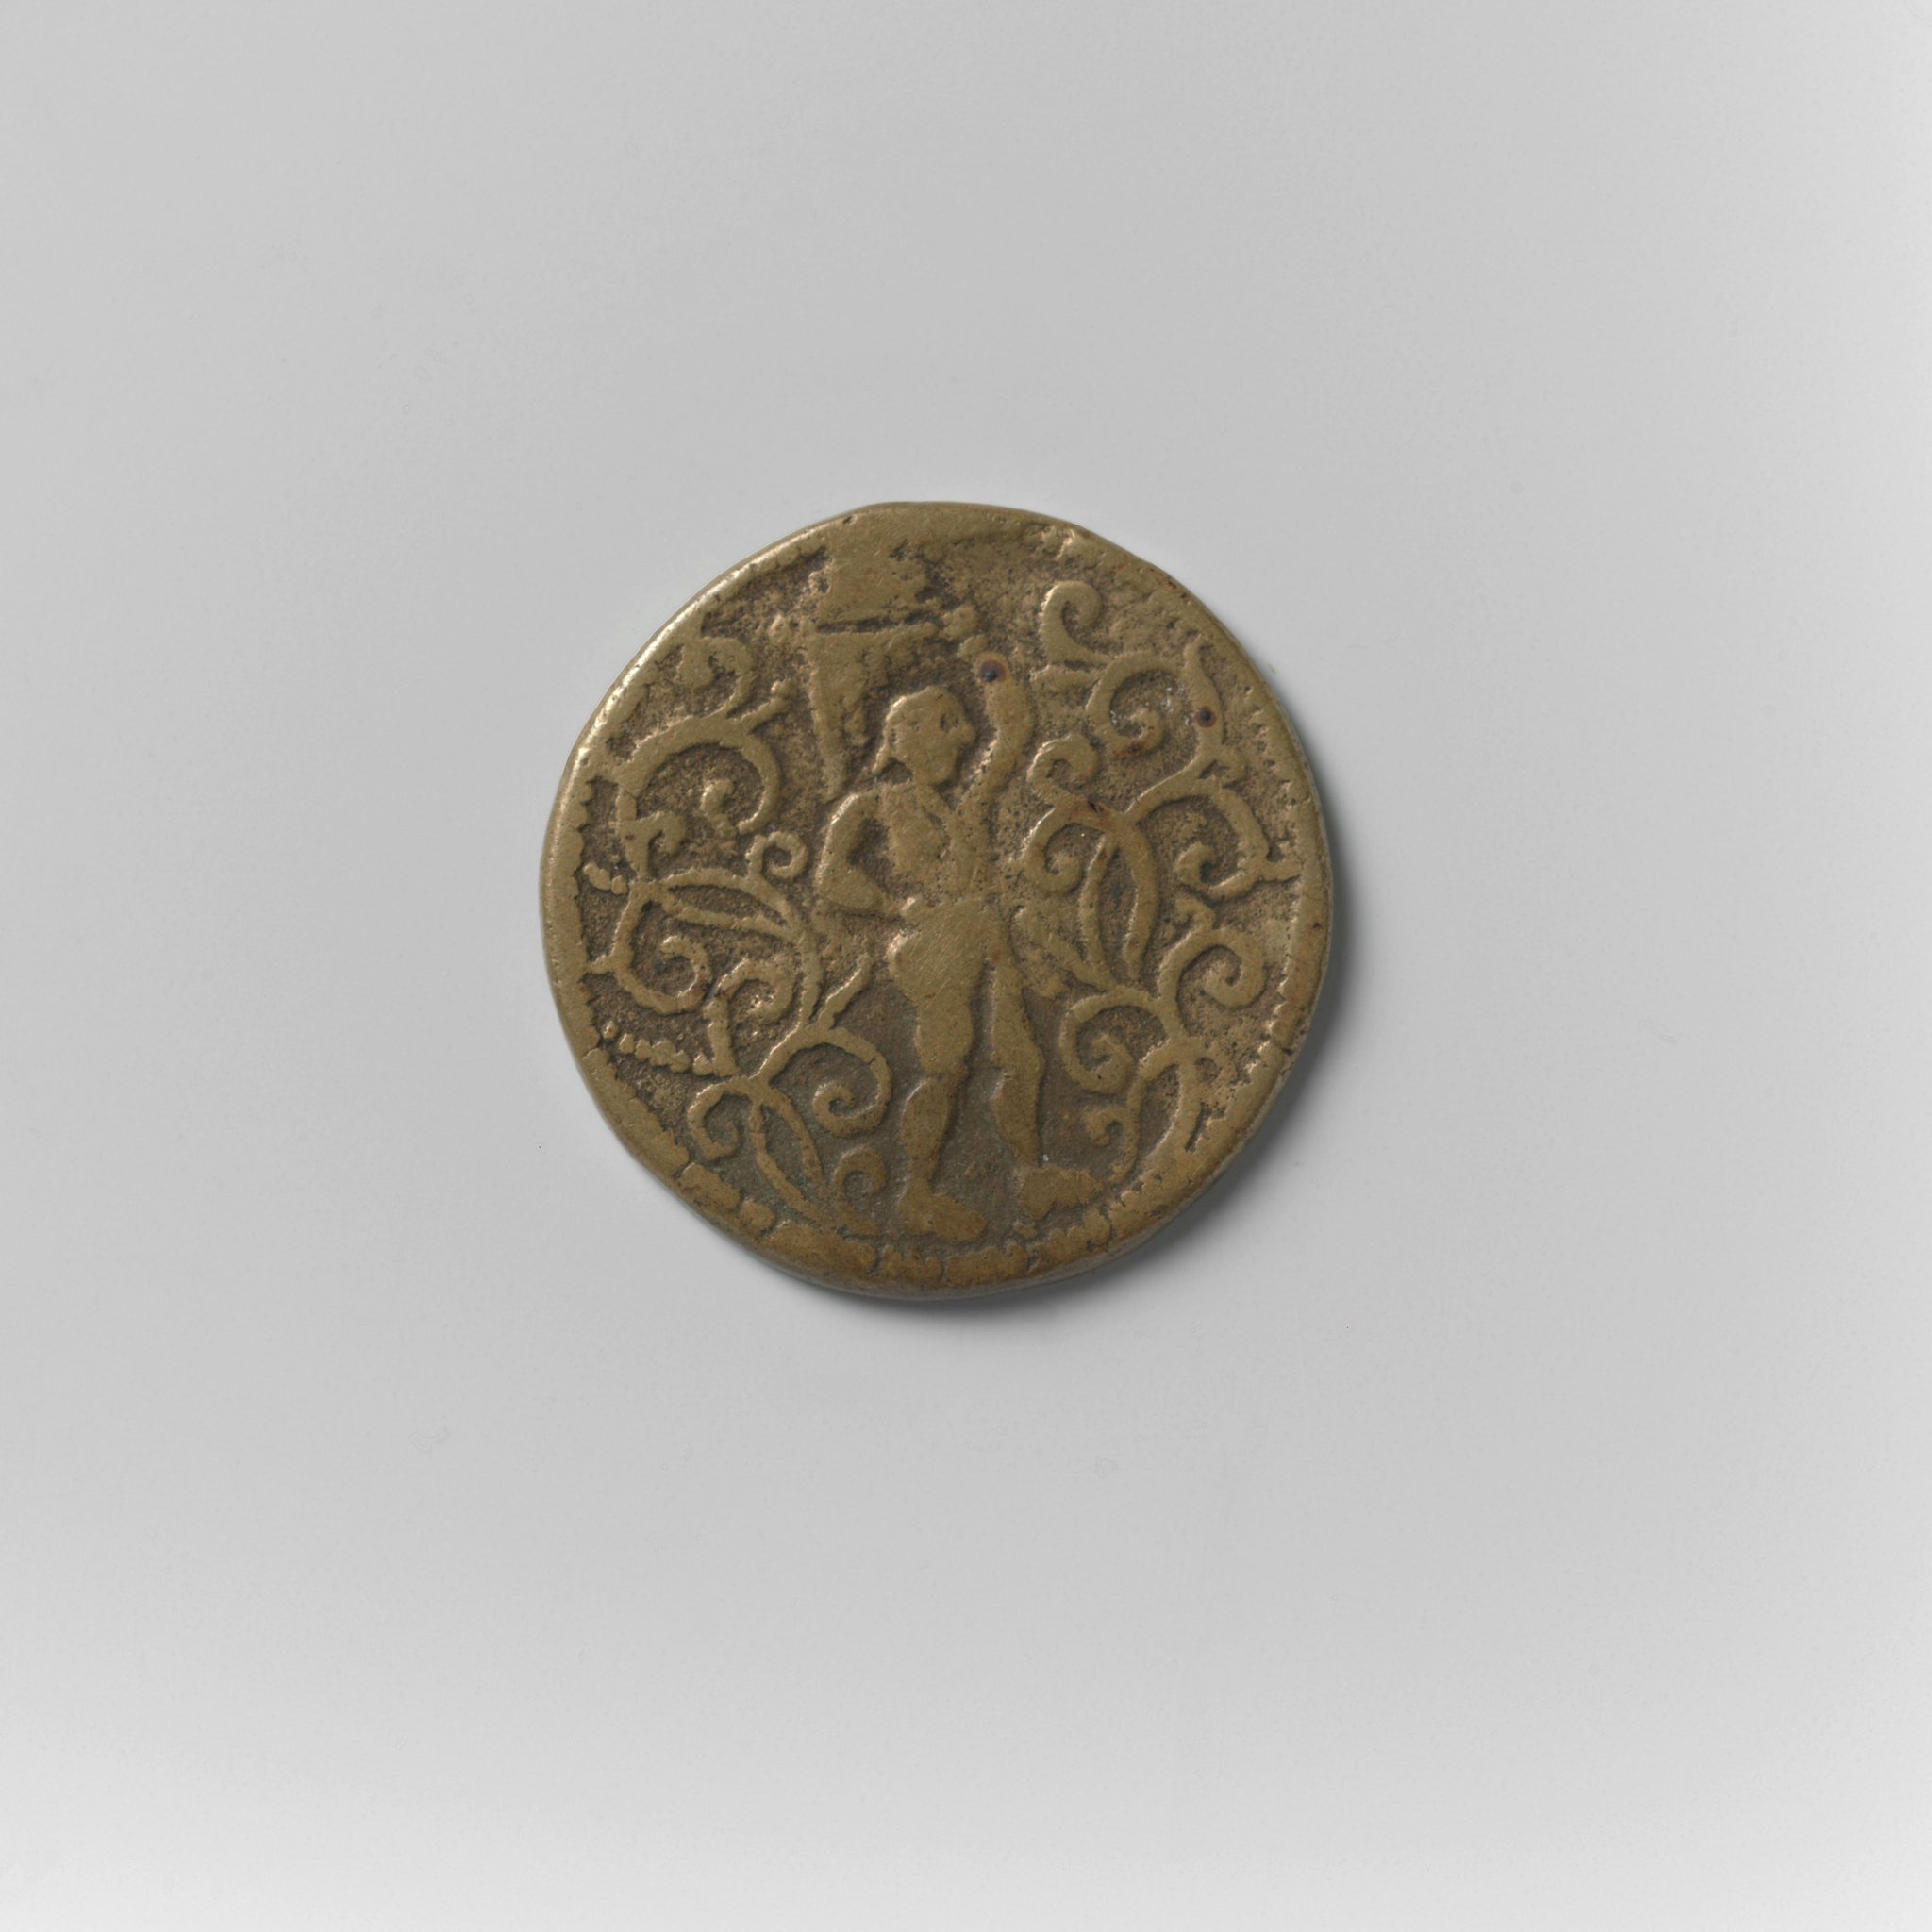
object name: history medal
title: Presentiepenning van het Turfdragersgilde te Amsterdam, 1619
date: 1619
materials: brass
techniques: casting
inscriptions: inscription: ‘TVRF / DRAGERS / GILDT’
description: Gegoten messing penning, op de voorzijde een turfdrager op versierd veld, met omschrift, op de keerzijde het opschrift TVRF DRAGERS (GILDT) tussen versieringen